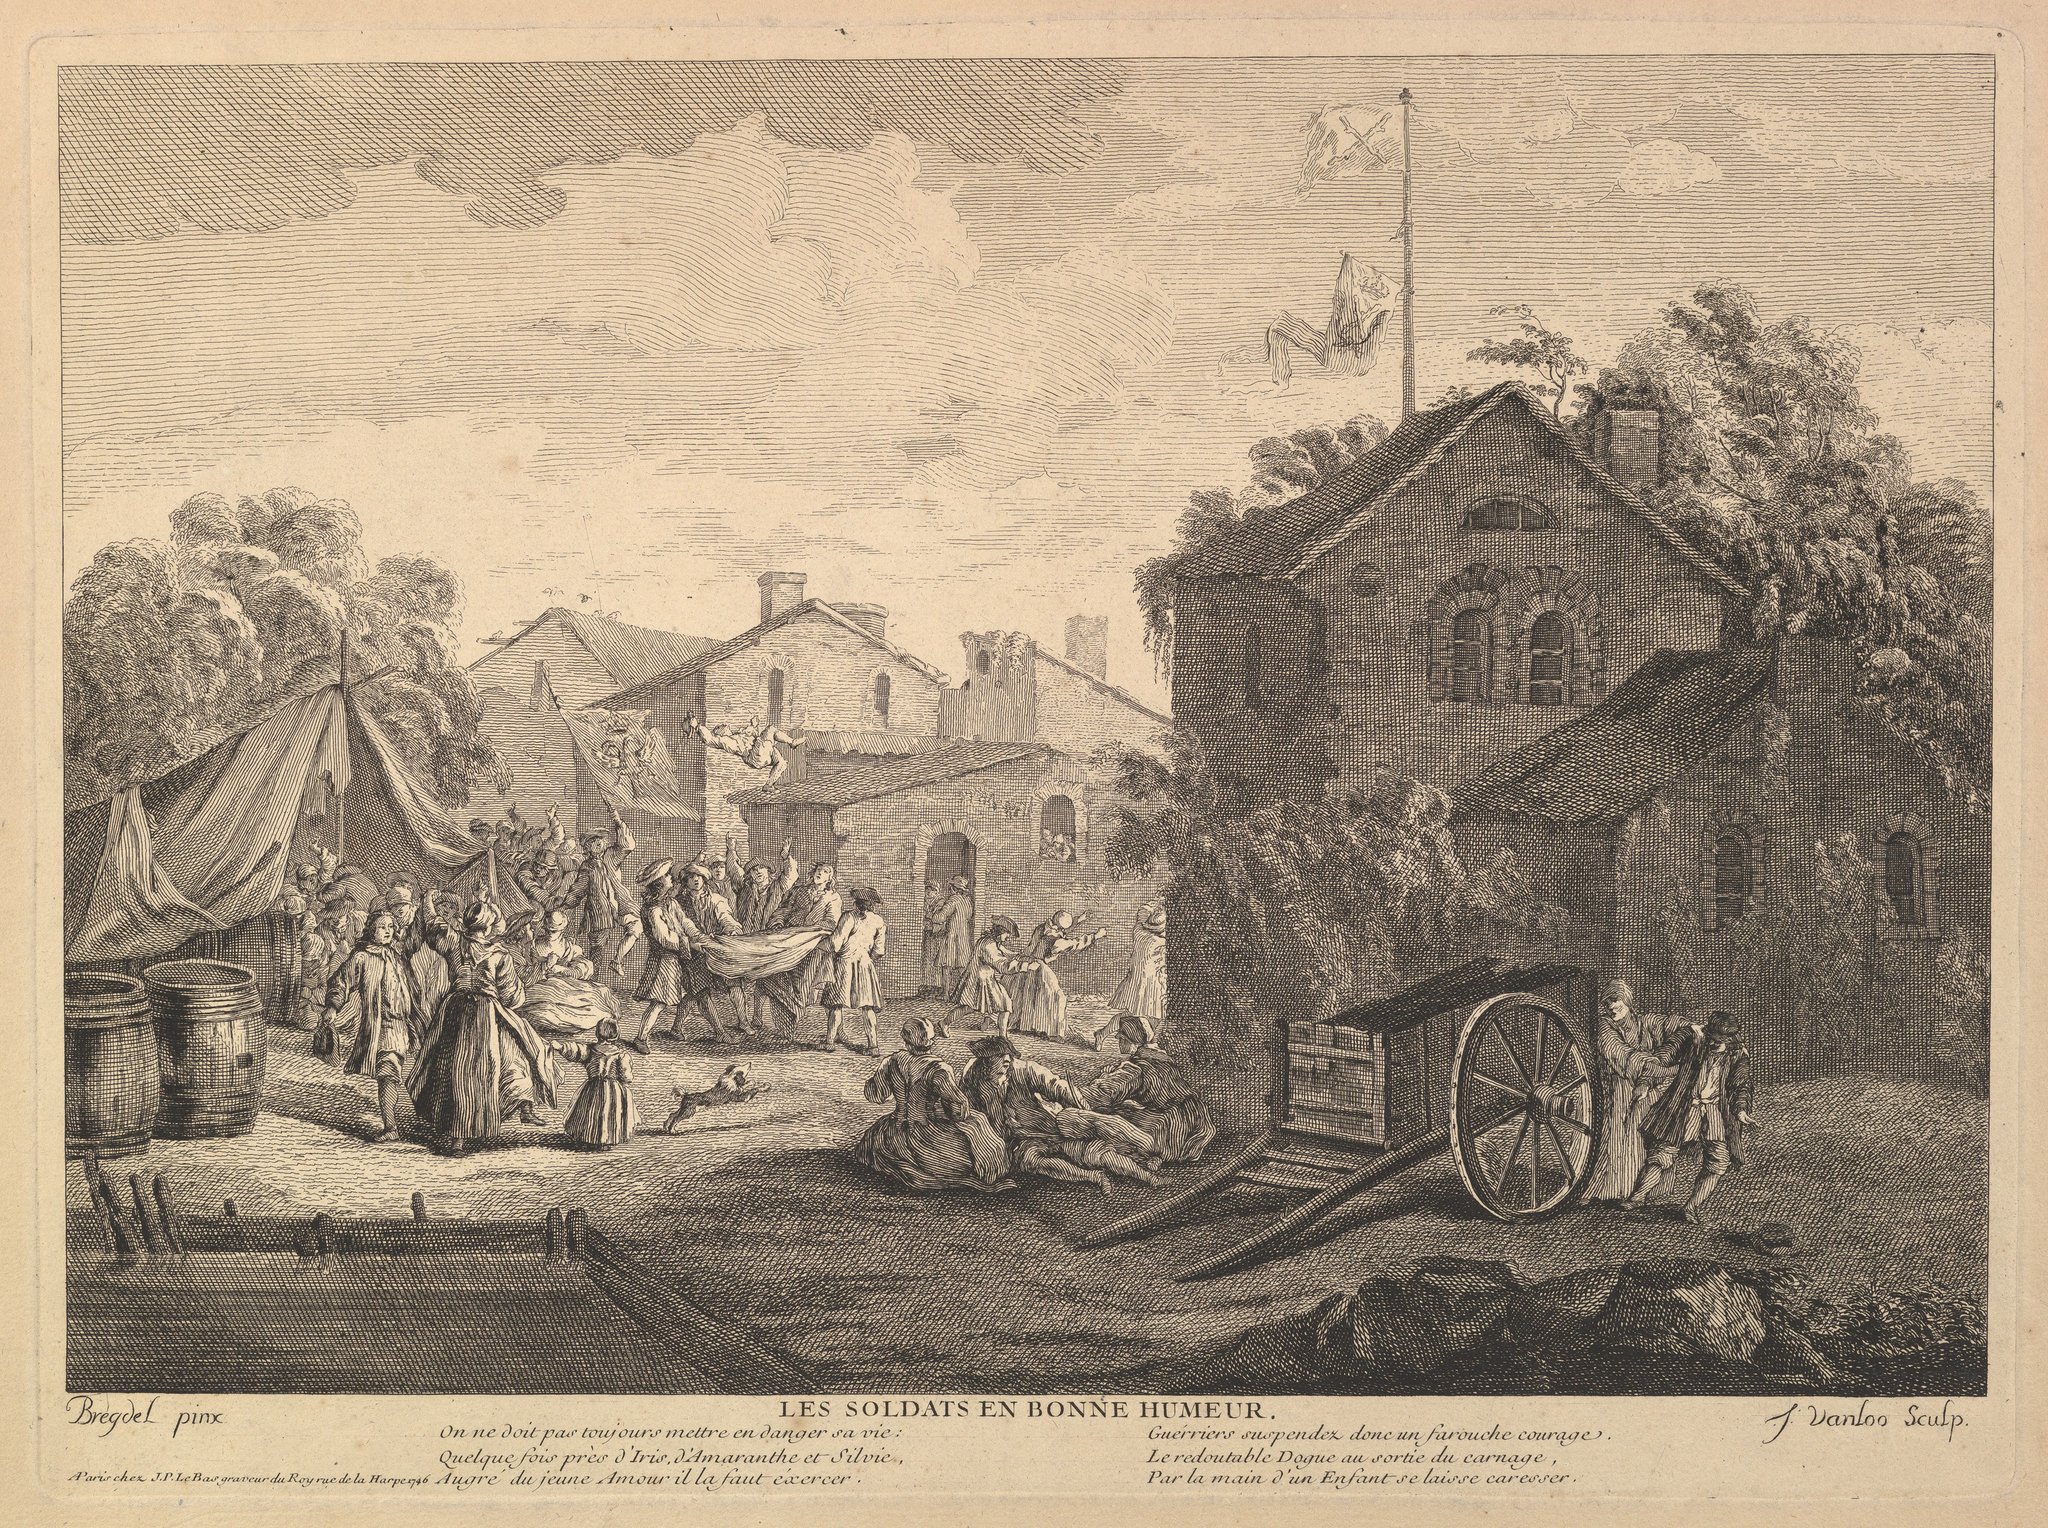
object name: print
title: Soldiers in a Good Mood (Les Soldats en Bonne Humeur)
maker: carel breydel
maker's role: artist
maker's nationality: flemish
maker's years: 1678-1733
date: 1746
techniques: engraving, etching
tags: houses,soldiers,men,women